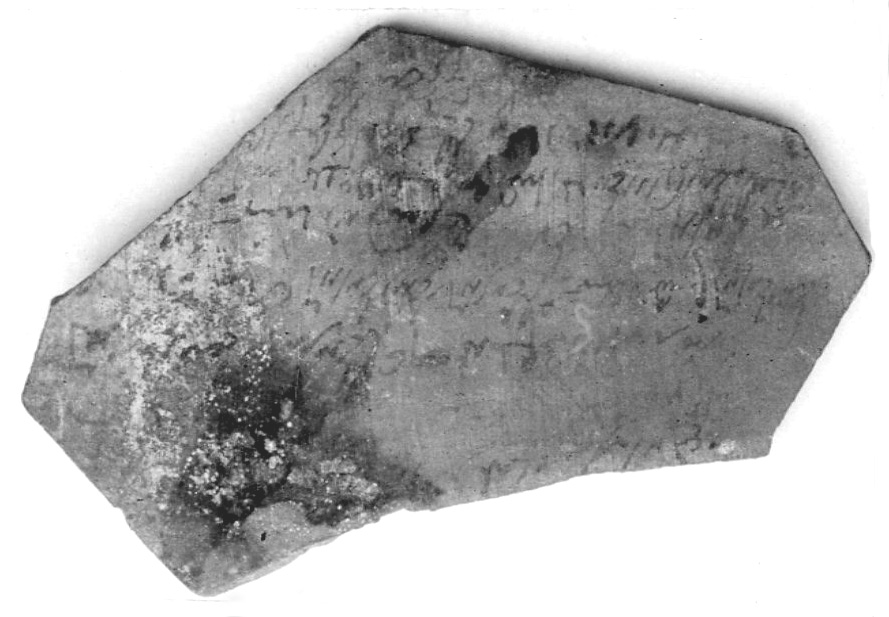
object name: ostracon, tax receipt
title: Ostracon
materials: ink, pottery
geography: egypt